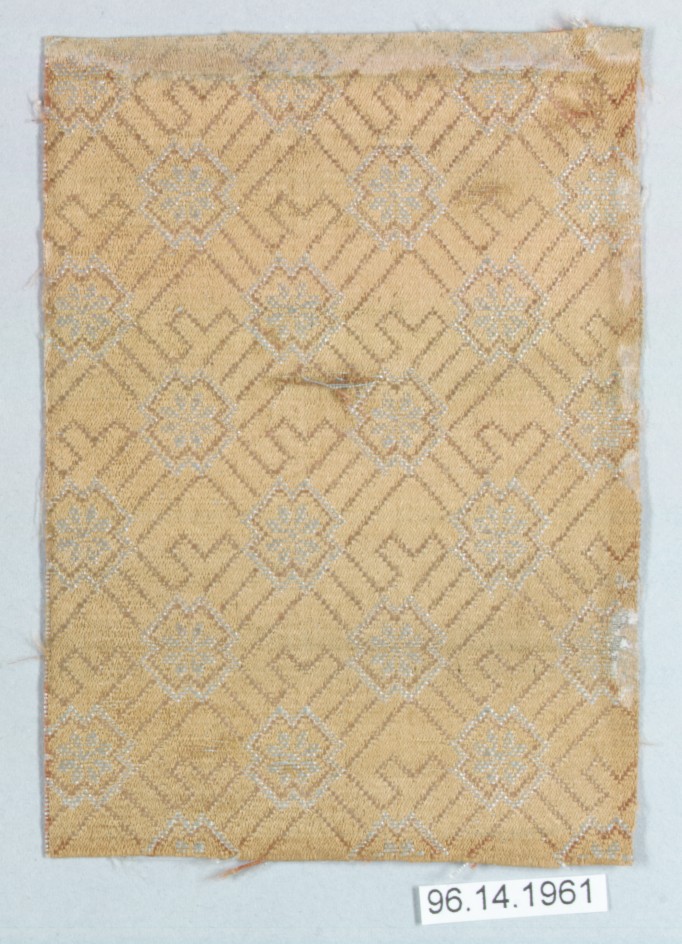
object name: piece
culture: japanese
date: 1801-1900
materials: silk